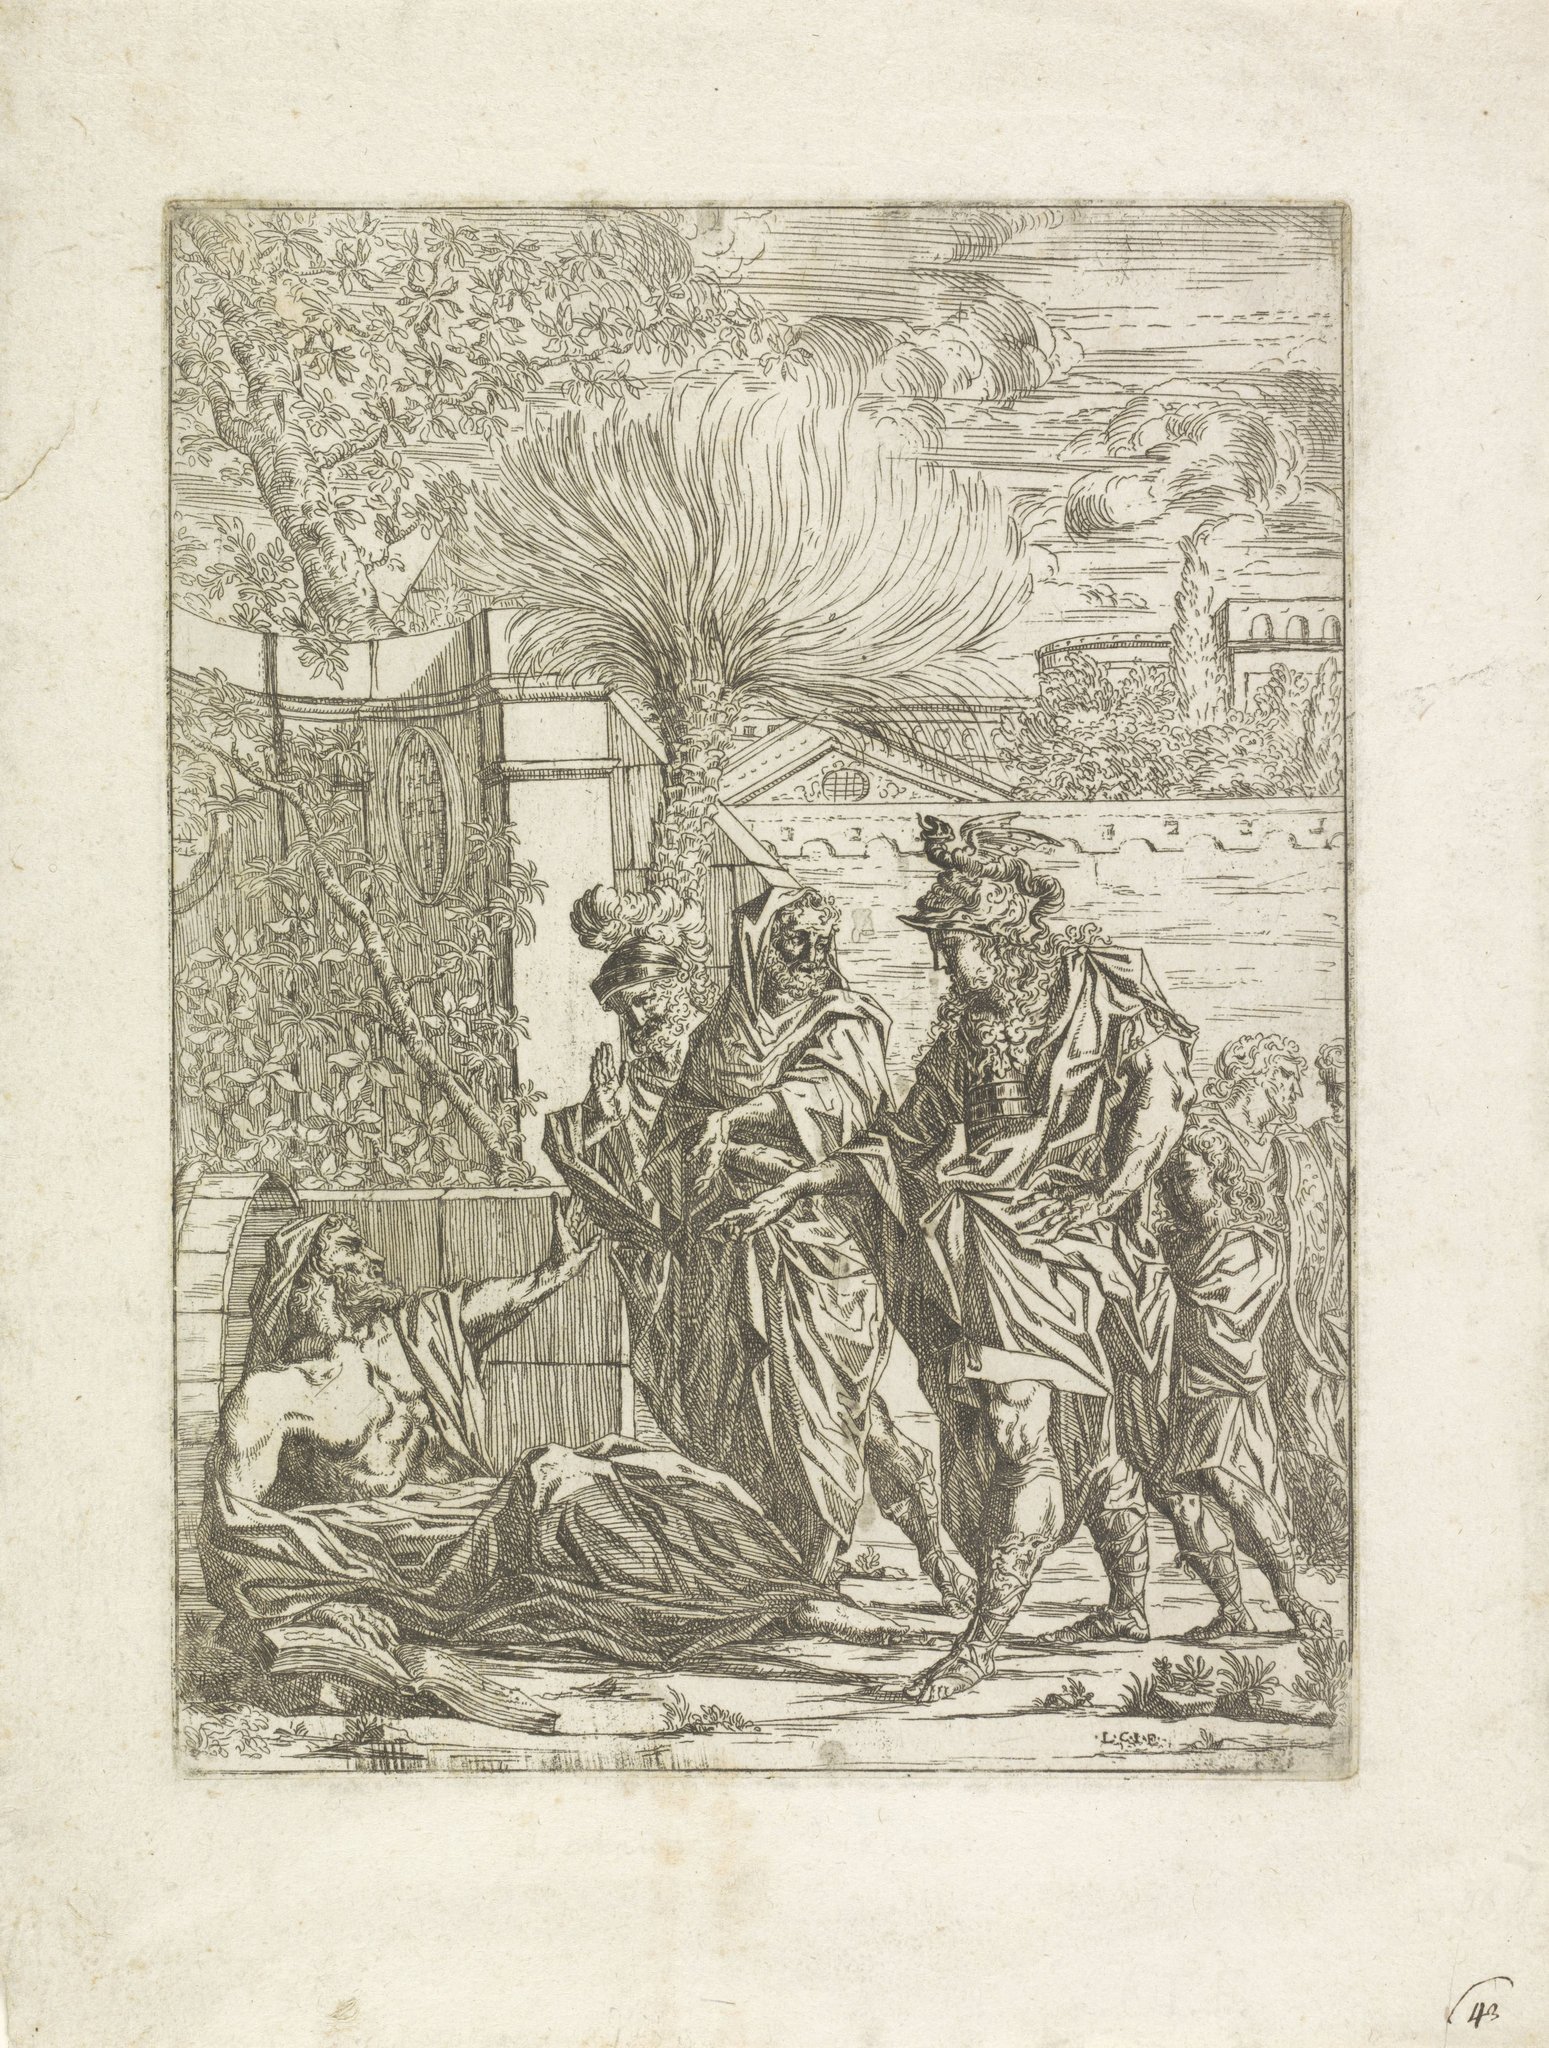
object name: print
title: Diogenes en Alexander de Grote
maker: ludovico cavazza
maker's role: print maker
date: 1700-1725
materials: paper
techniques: etching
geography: bologna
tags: alexander's visit to diogenes, who sits by his barrel and asks alexander to get out of his light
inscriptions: number: ‘(43’, collector's mark: Lugt 2760, collector's mark: Lugt 2228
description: De filosoof Diogenes zit voor zijn ton. Hij wenkt naar Alexander de Grote en zijn gevolg opzij te gaan, zodat hij niet langer in hun schaduw zit.